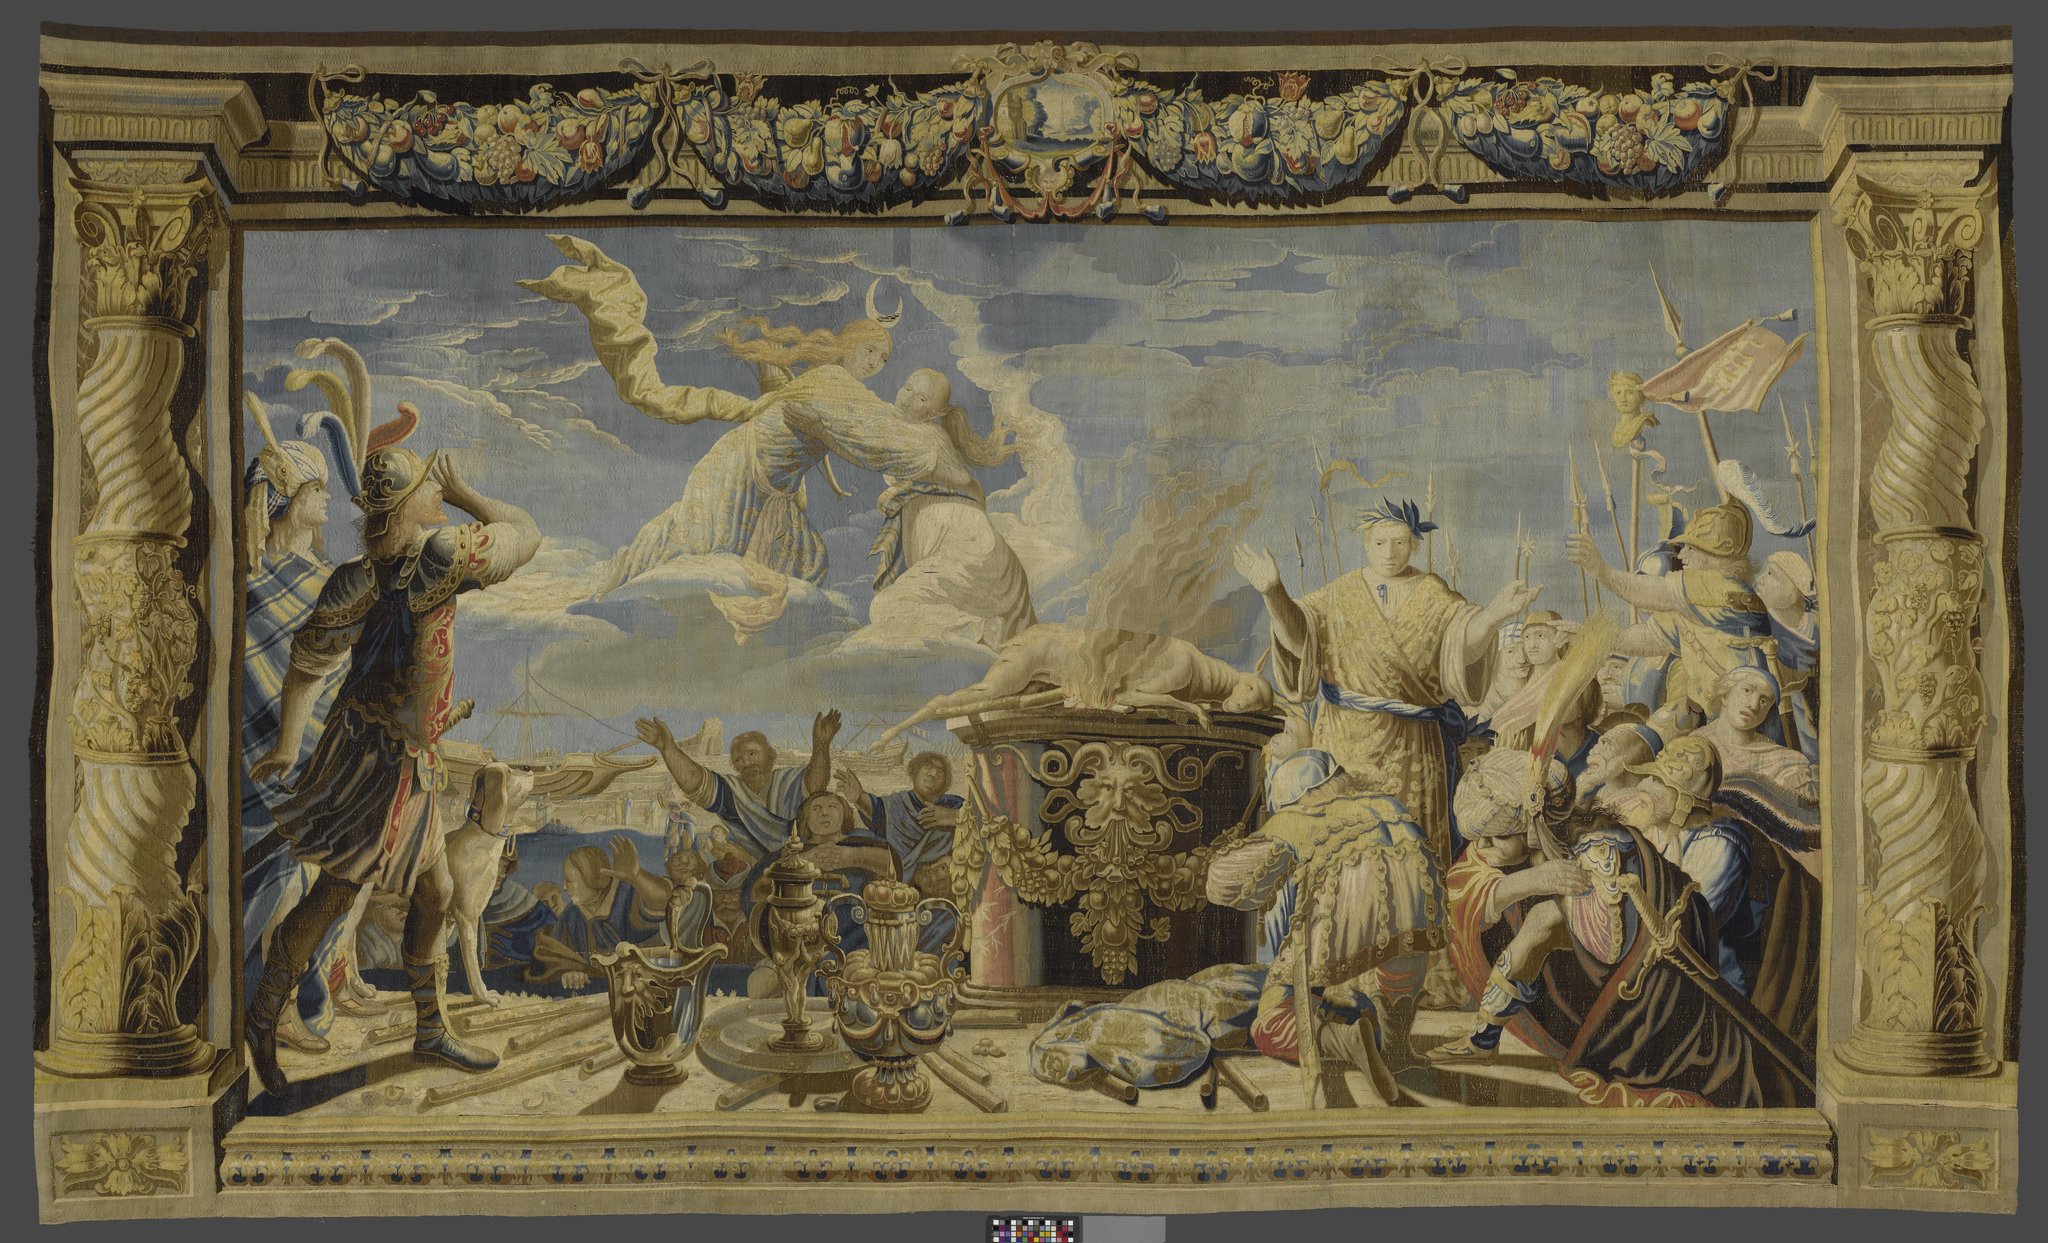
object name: tapestry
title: Wandtapijt met de interventie van Artemis tijdens de voorbereiding van het offer van Iphigeneia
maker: salomon de bray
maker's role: draughtsman, print maker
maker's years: 1597-1664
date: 1648-1662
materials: silk, wool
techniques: tapestry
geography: amsterdam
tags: iphigenia is saved by diana, who puts a stag (hind) in her place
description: Wandtapijt met de interventie van Artemis tijdens de voorbereiding van het offer van Iphigeneia. Centraal staat het altaar, waarop een hinde de plaats van Iphigeneia reeds heeft ingenomen. In de lucht trekt Artemis, herkenbaar aan de maansikkel op haar hoofd, Iphigeneia mee. Lins kijkt Orestes, zijn ogen beschermend tegen het goddelijke licht, in gezelschap van van zijn vriend Pylades, naar het gebeuren in de wolken. Diep geknield is uiterst rechts Agamemnon weergegeven, met een grote tulband op het hoofd, voorzien van een pluim en een kroon bovenop. Achter hem maakt een priester, met een lauwerkrans op het hoofd een zegenend gebaar.